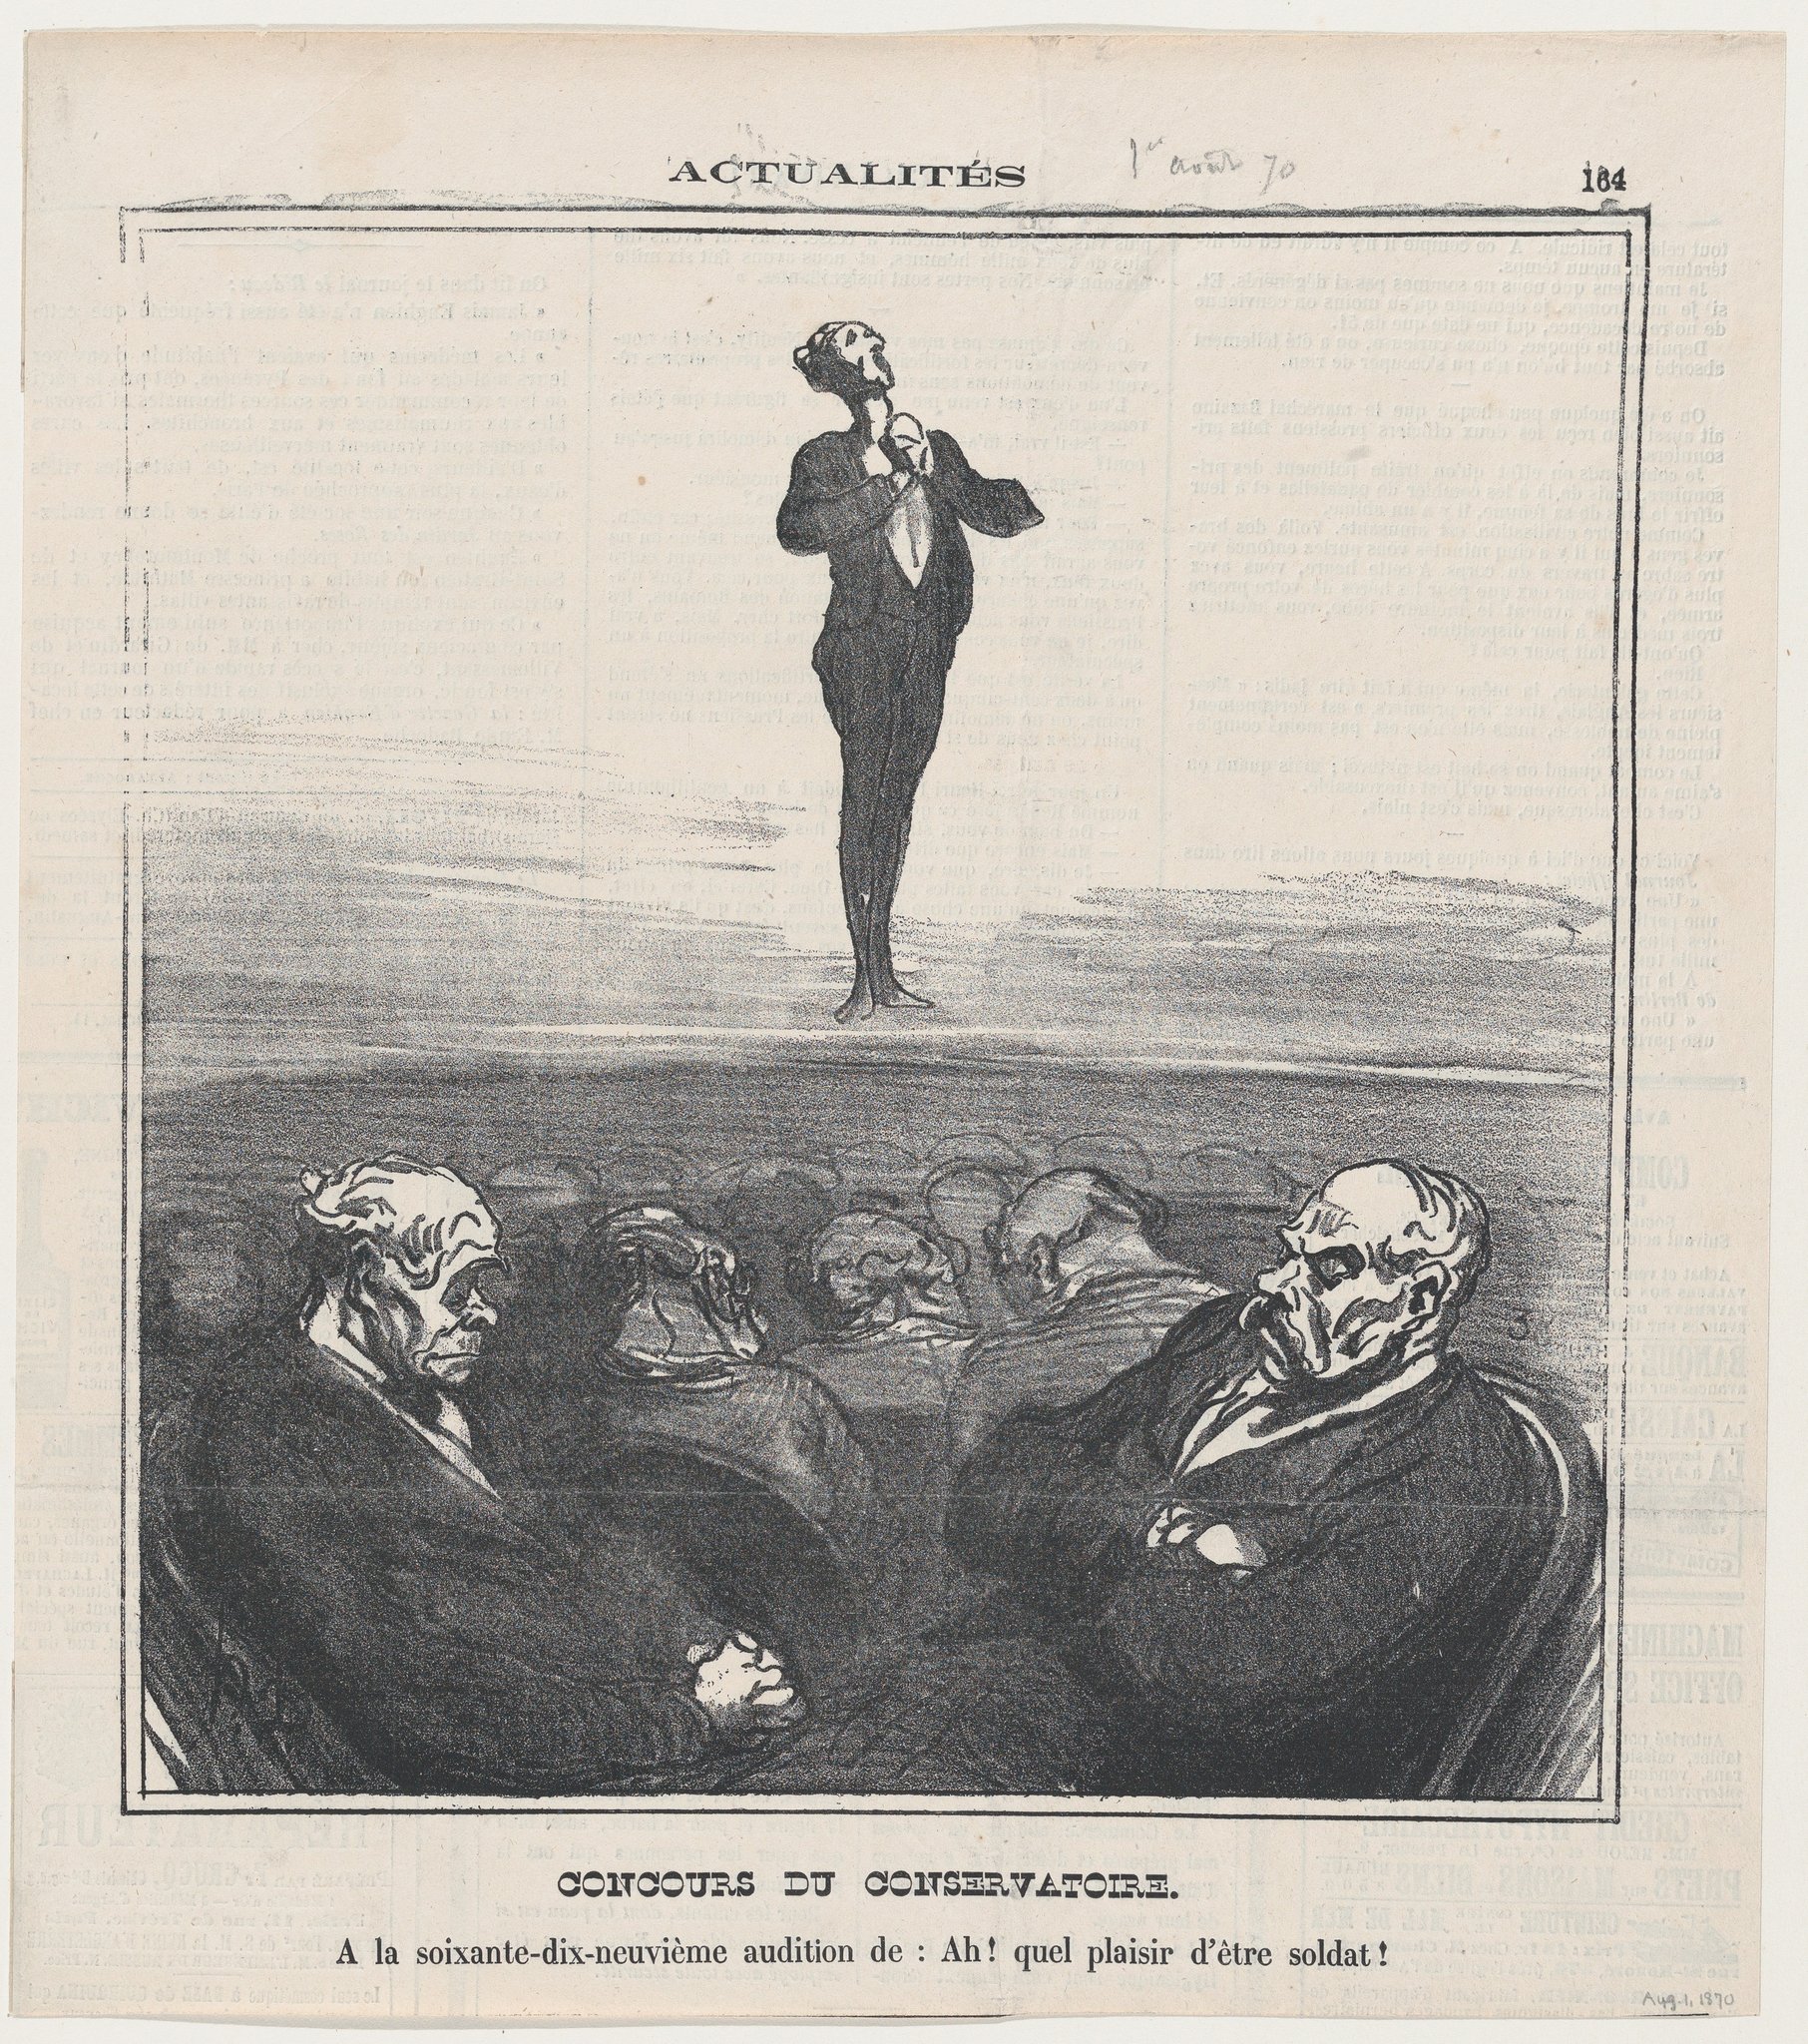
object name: print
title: The competition at the conservatory: At the 79th audition of "Oh, what a pleasure to be a soldier!", from 'News of the day,' published in Le Charivari, August 1, 1870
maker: honoré daumier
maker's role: artist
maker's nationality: french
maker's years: 1808-1879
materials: paper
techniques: lithograph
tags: satire,men